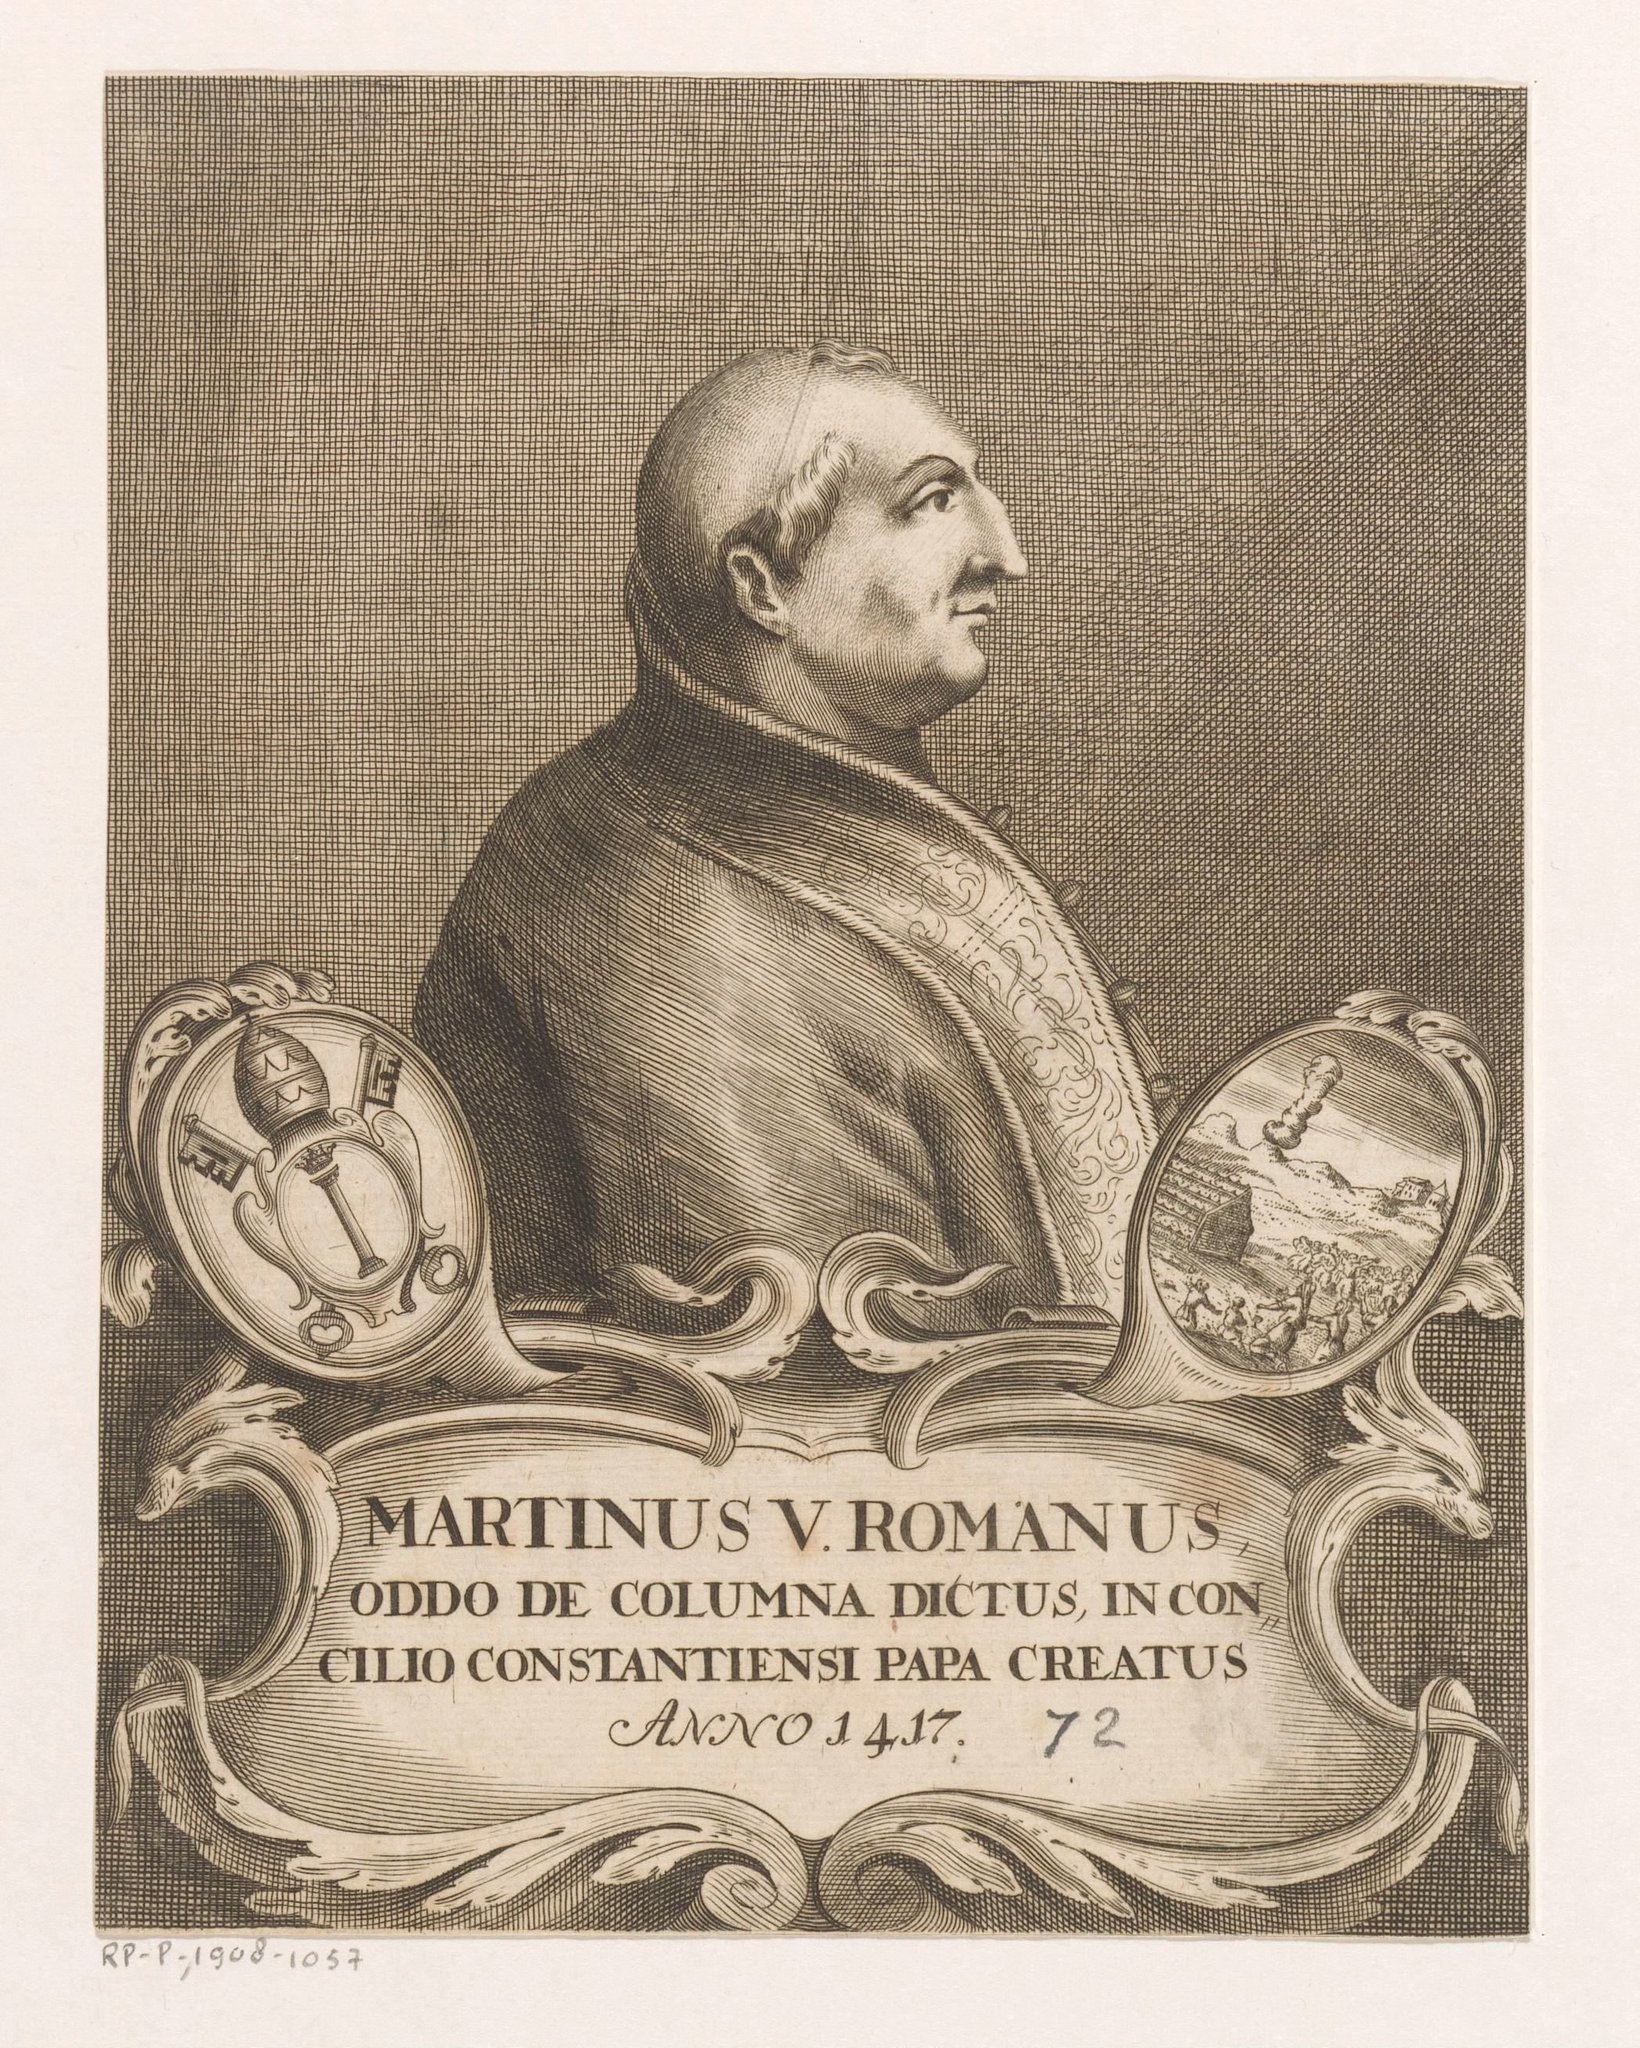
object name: print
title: Portret van paus Martinus V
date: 1700-1750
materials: paper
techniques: engraving, etching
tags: rome, clergyman, historical persons, pope, armorial bearing, heraldry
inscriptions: collector's mark: Lugt 2228